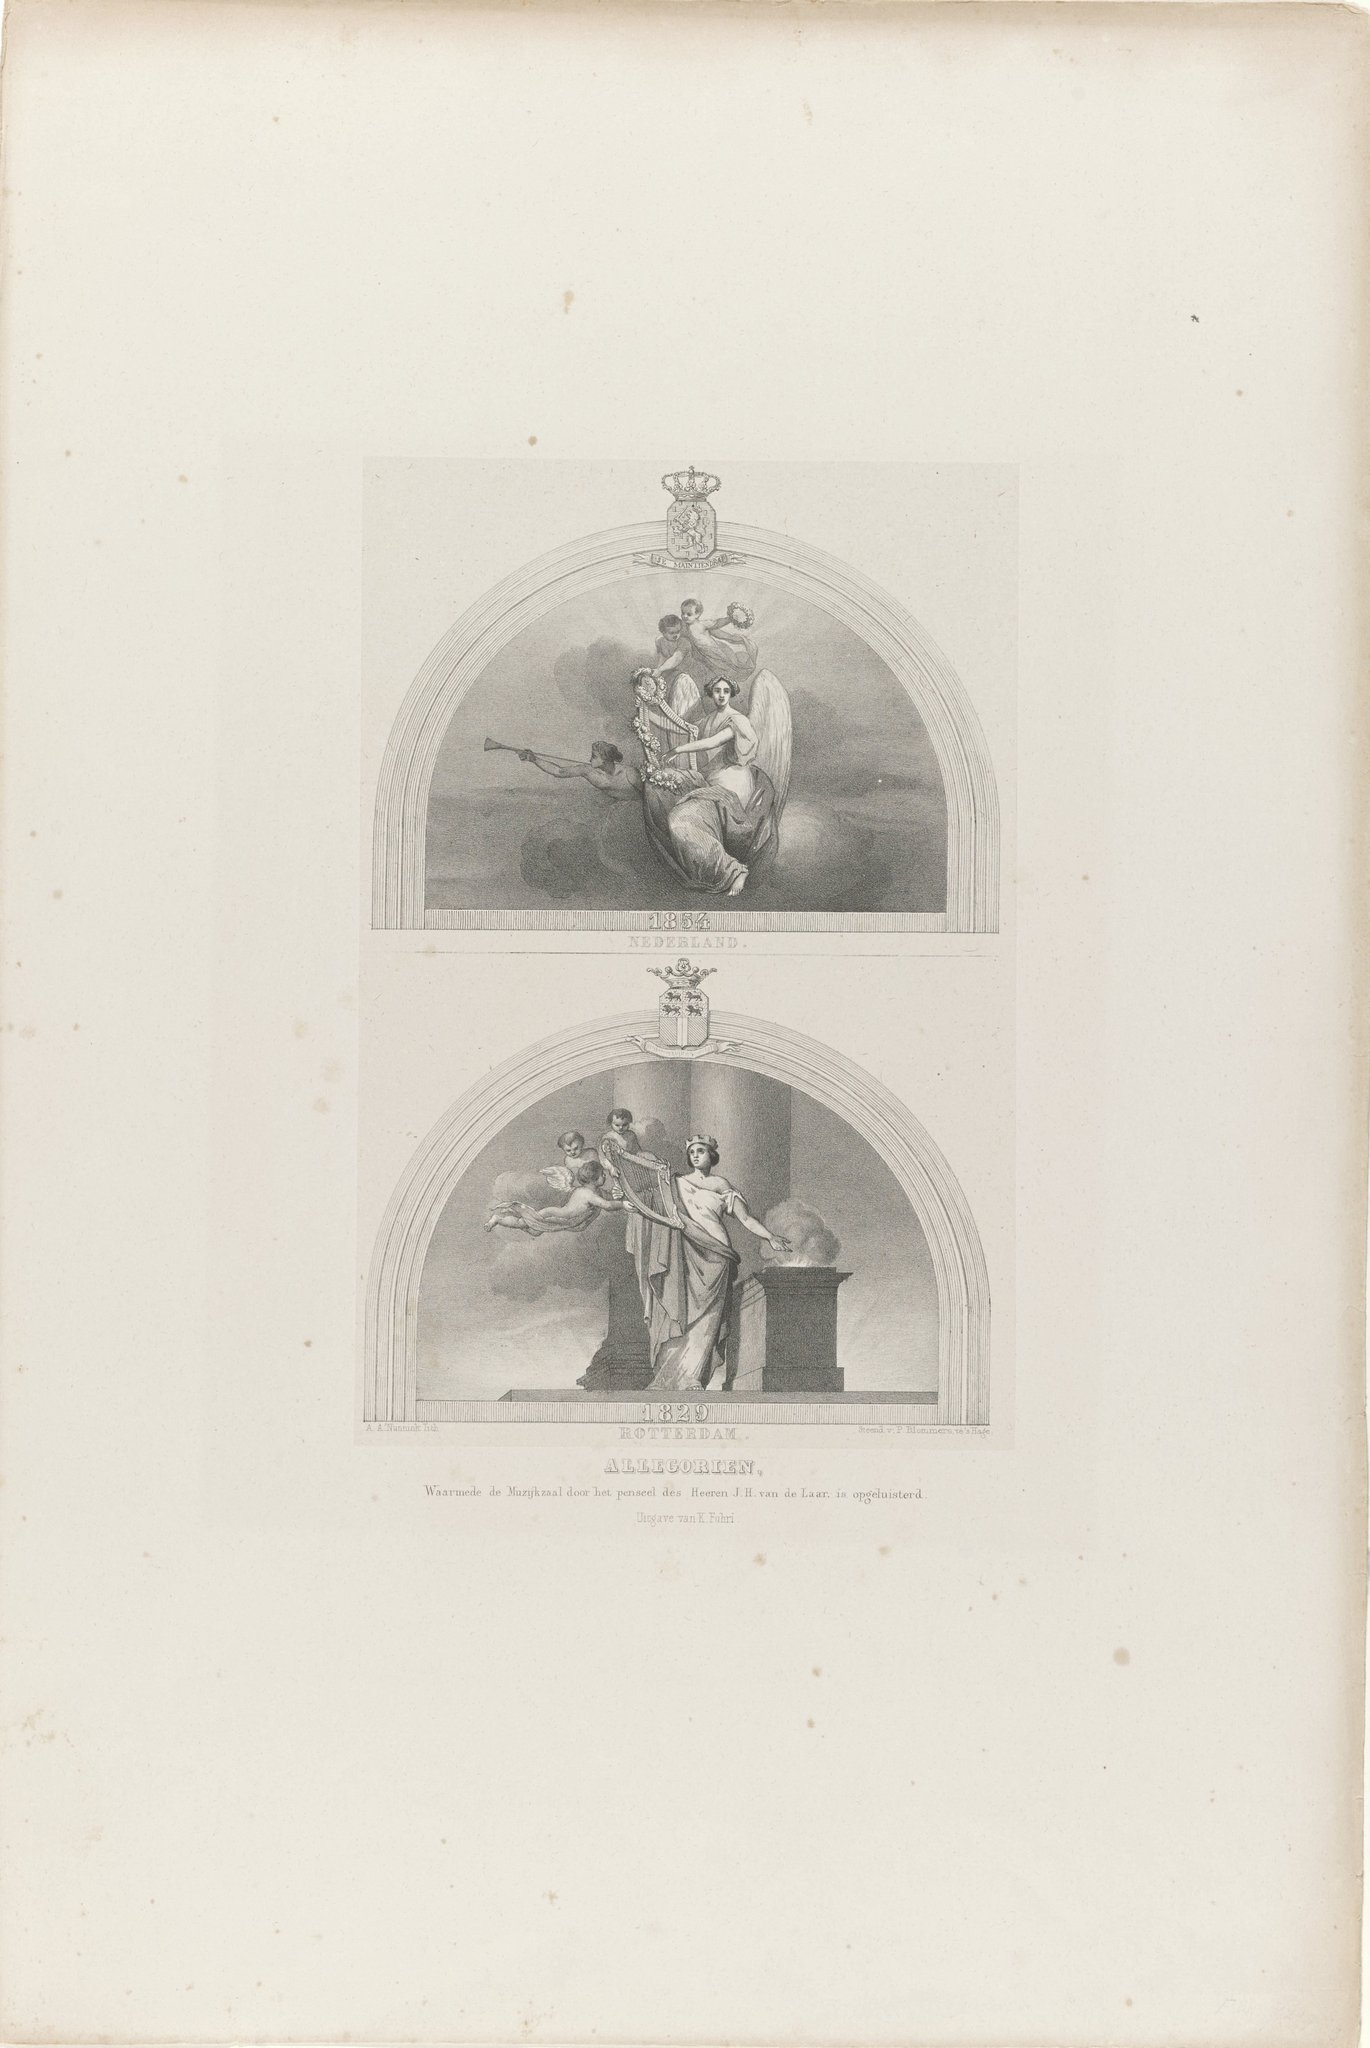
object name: print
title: Allegorien, Waarmede de Muzijkzaal door het penseel des Heeren J.H. van de Laar, is opgeluisterd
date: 1855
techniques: printmaking, lithograph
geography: netherlands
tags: 'musica', symbolic representations, allegories and emblems ~ music; 'musica'(ripa), rotterdam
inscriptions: collector's mark: Lugt 2228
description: Twee allegorische voorstellingen ter versiering van het nieuwe Feestgebouw waar het muziekfeest is gehouden, 1854. De bovenste met het jaartal 1854 en 'Nederland', de onderste met het jaar 1829 en 'Rotterdam'. Onderdeel van een serie van twaalf portretten naar daguerrotypieën en twaalf stadsgezichten. Ter gelegenheid van het Muziekfeest ter viering van het 25-jarige bestaan van de Maatschappij ter Bevordering van Toonkunst in Rotterdam, 12-15 juli 1854.